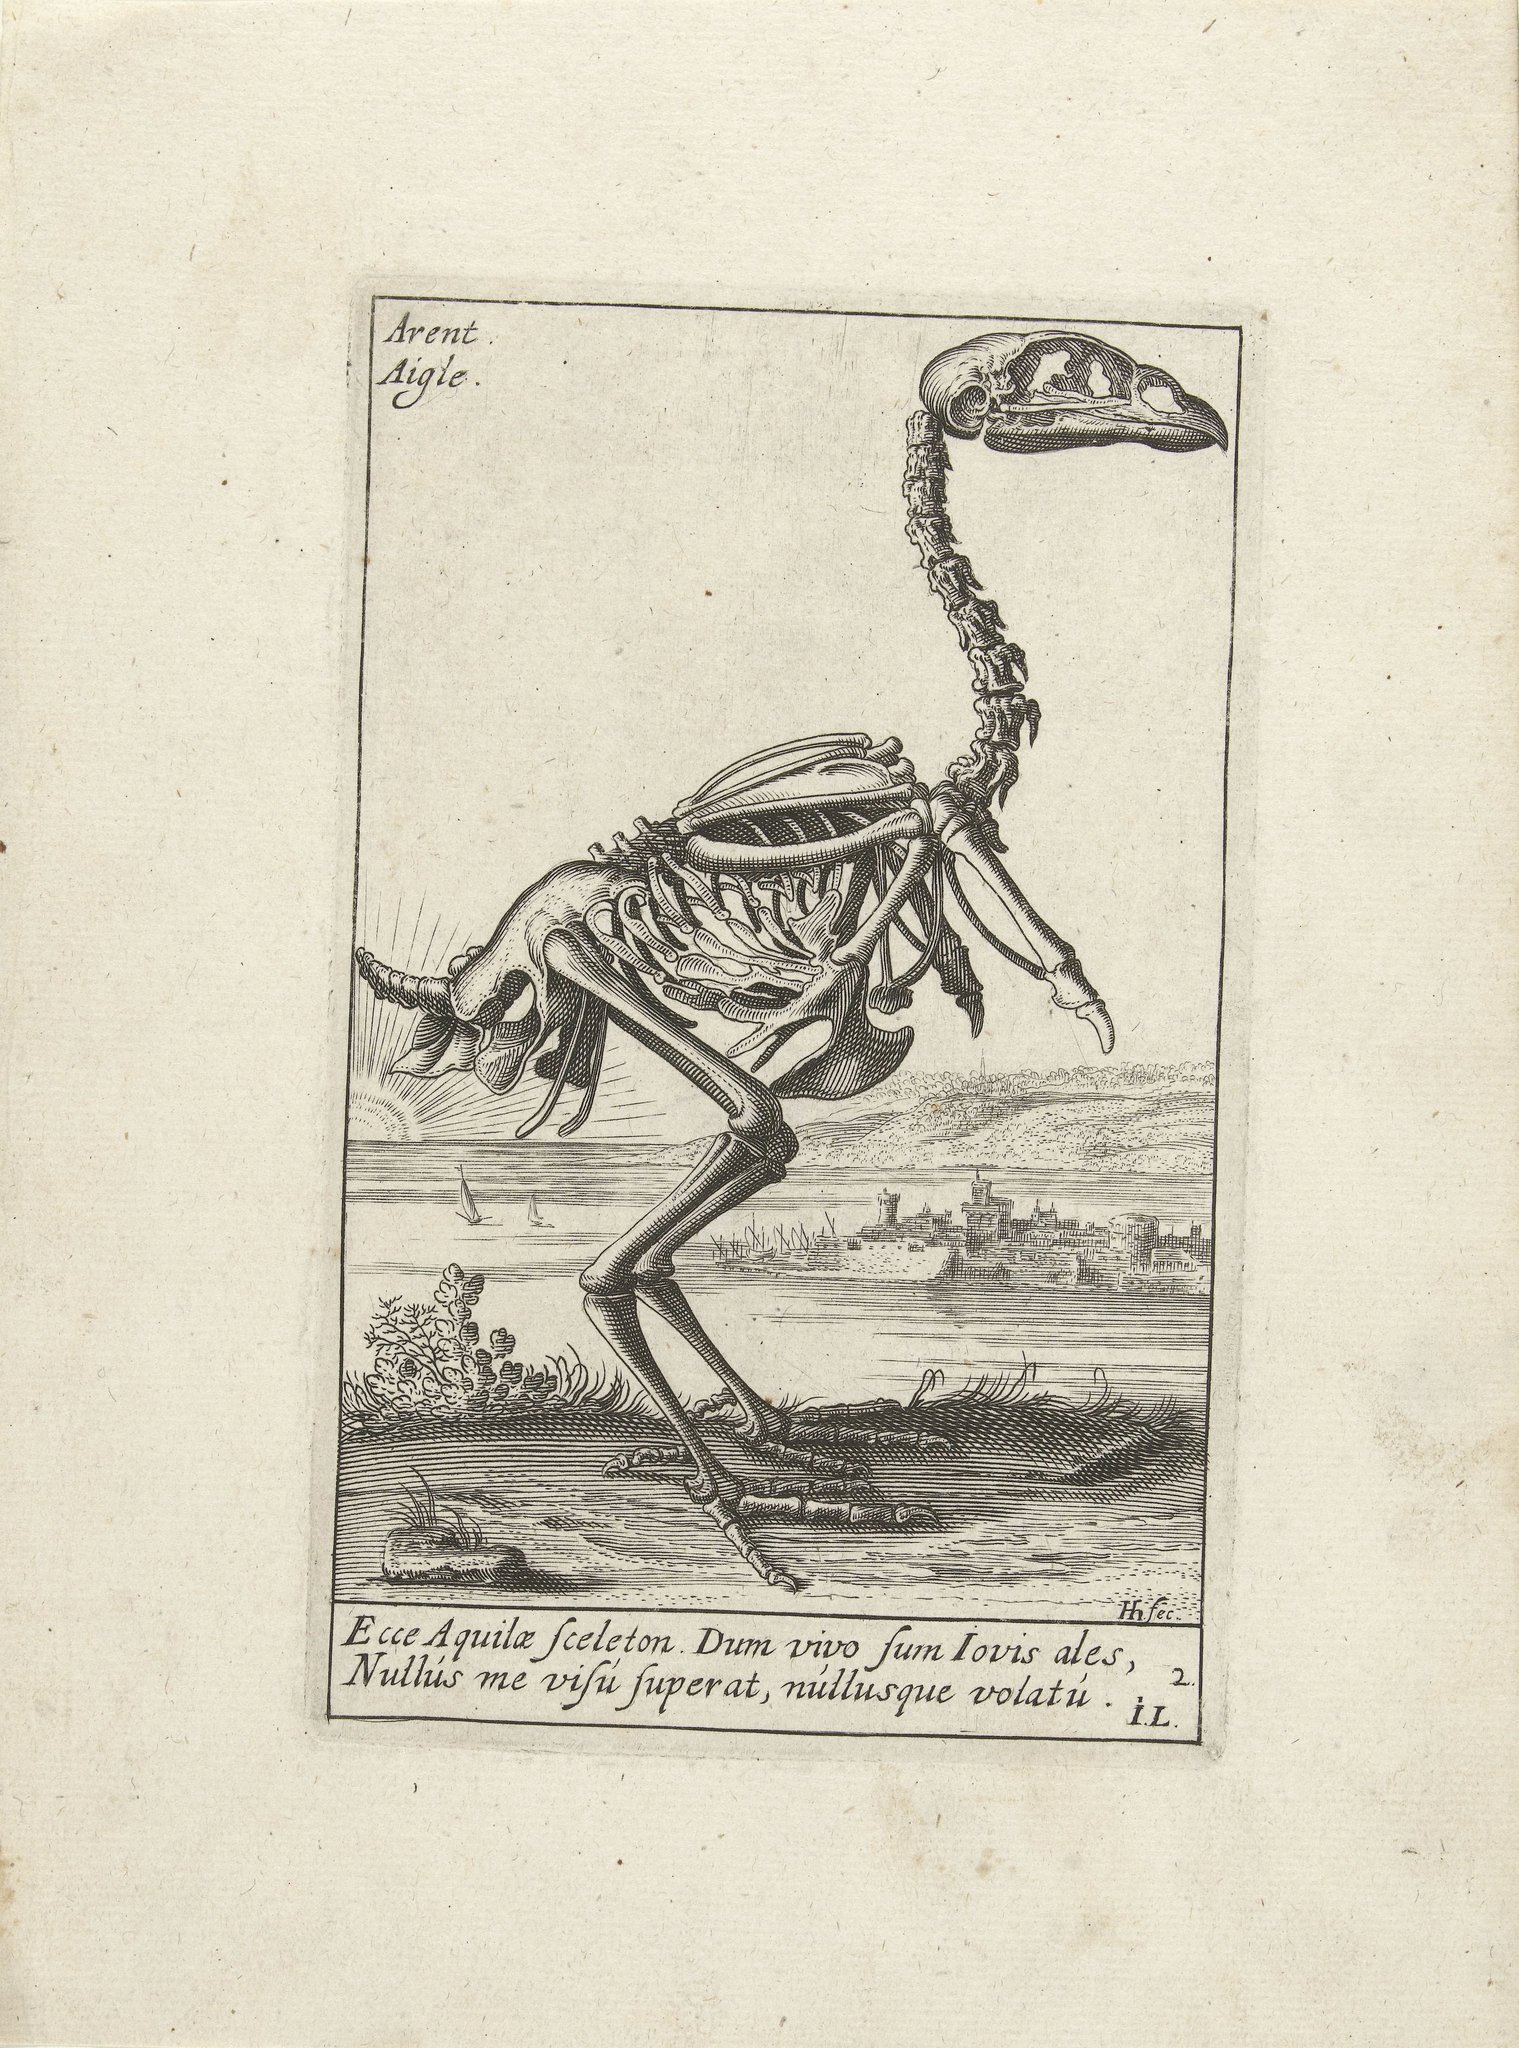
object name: print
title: Dierskeletten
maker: hendrick hondius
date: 1626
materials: paper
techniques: engraving, etching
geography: the hague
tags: animals (+ skeleton of an animal), predatory birds: eagle (+ skeleton of an animal)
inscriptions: inscription: ‘l.b.: Arent / Aigle; m.o. in kader: Ecce Aquilae sceleton. Dum vivo sum Iovis ales, Nullus me visu superat, nullusque volatu.; r.o.: 2 en I.L.’, collector's mark: Lugt 2228, signature and date: ‘r.o. Hh fec.’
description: Skelet van een staande arend, naar rechts. Een stad aan een kust op de achtergrond. Prent uit een serie met voorstellingen van skeletten door de prentmakers Hendrick Hondius I (NewHollst.243-258), Andries Jacobsz. Stock (Hollst.4-10) en Simon Frisius.